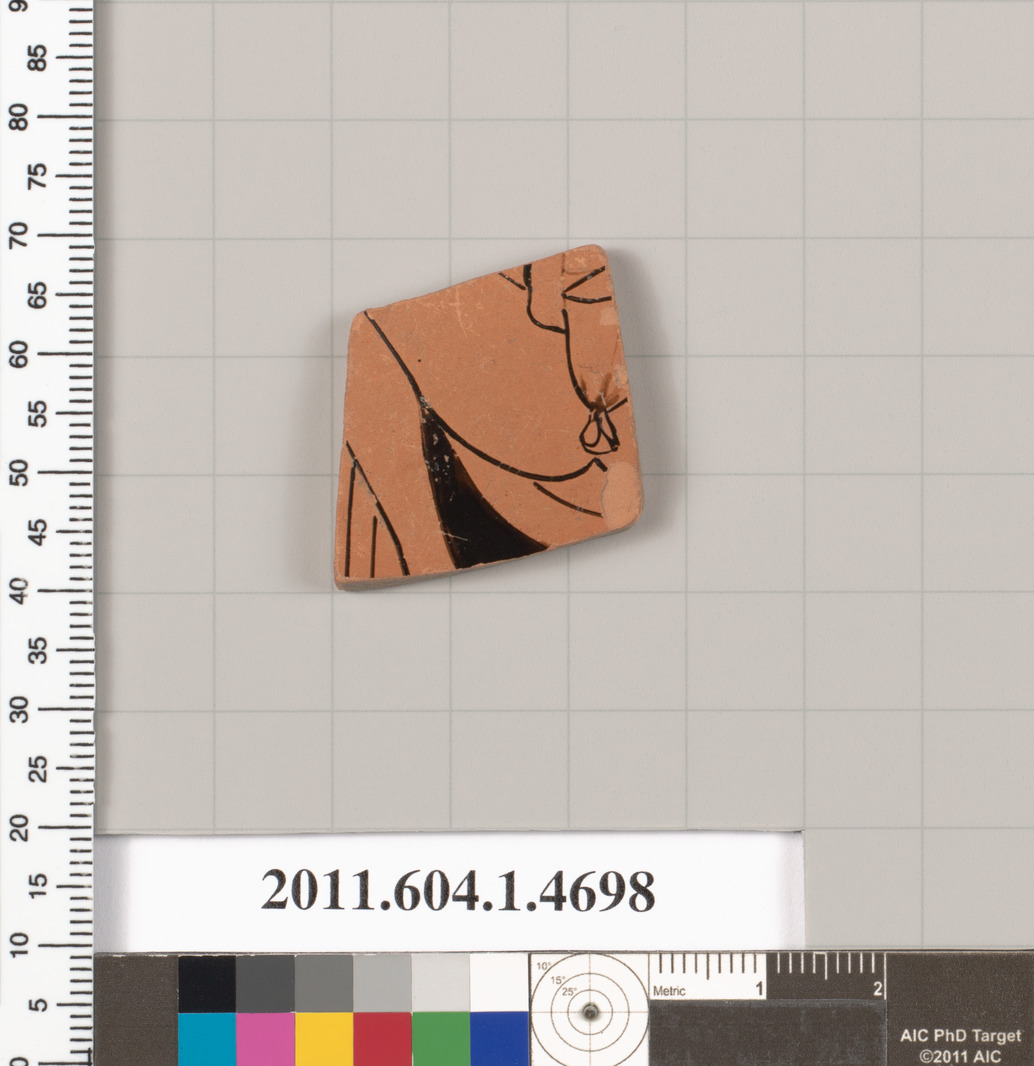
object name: kylix fragment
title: Terracotta fragment of a kylix (drinking cup)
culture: greek, attic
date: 500-480 BCE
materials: terracotta